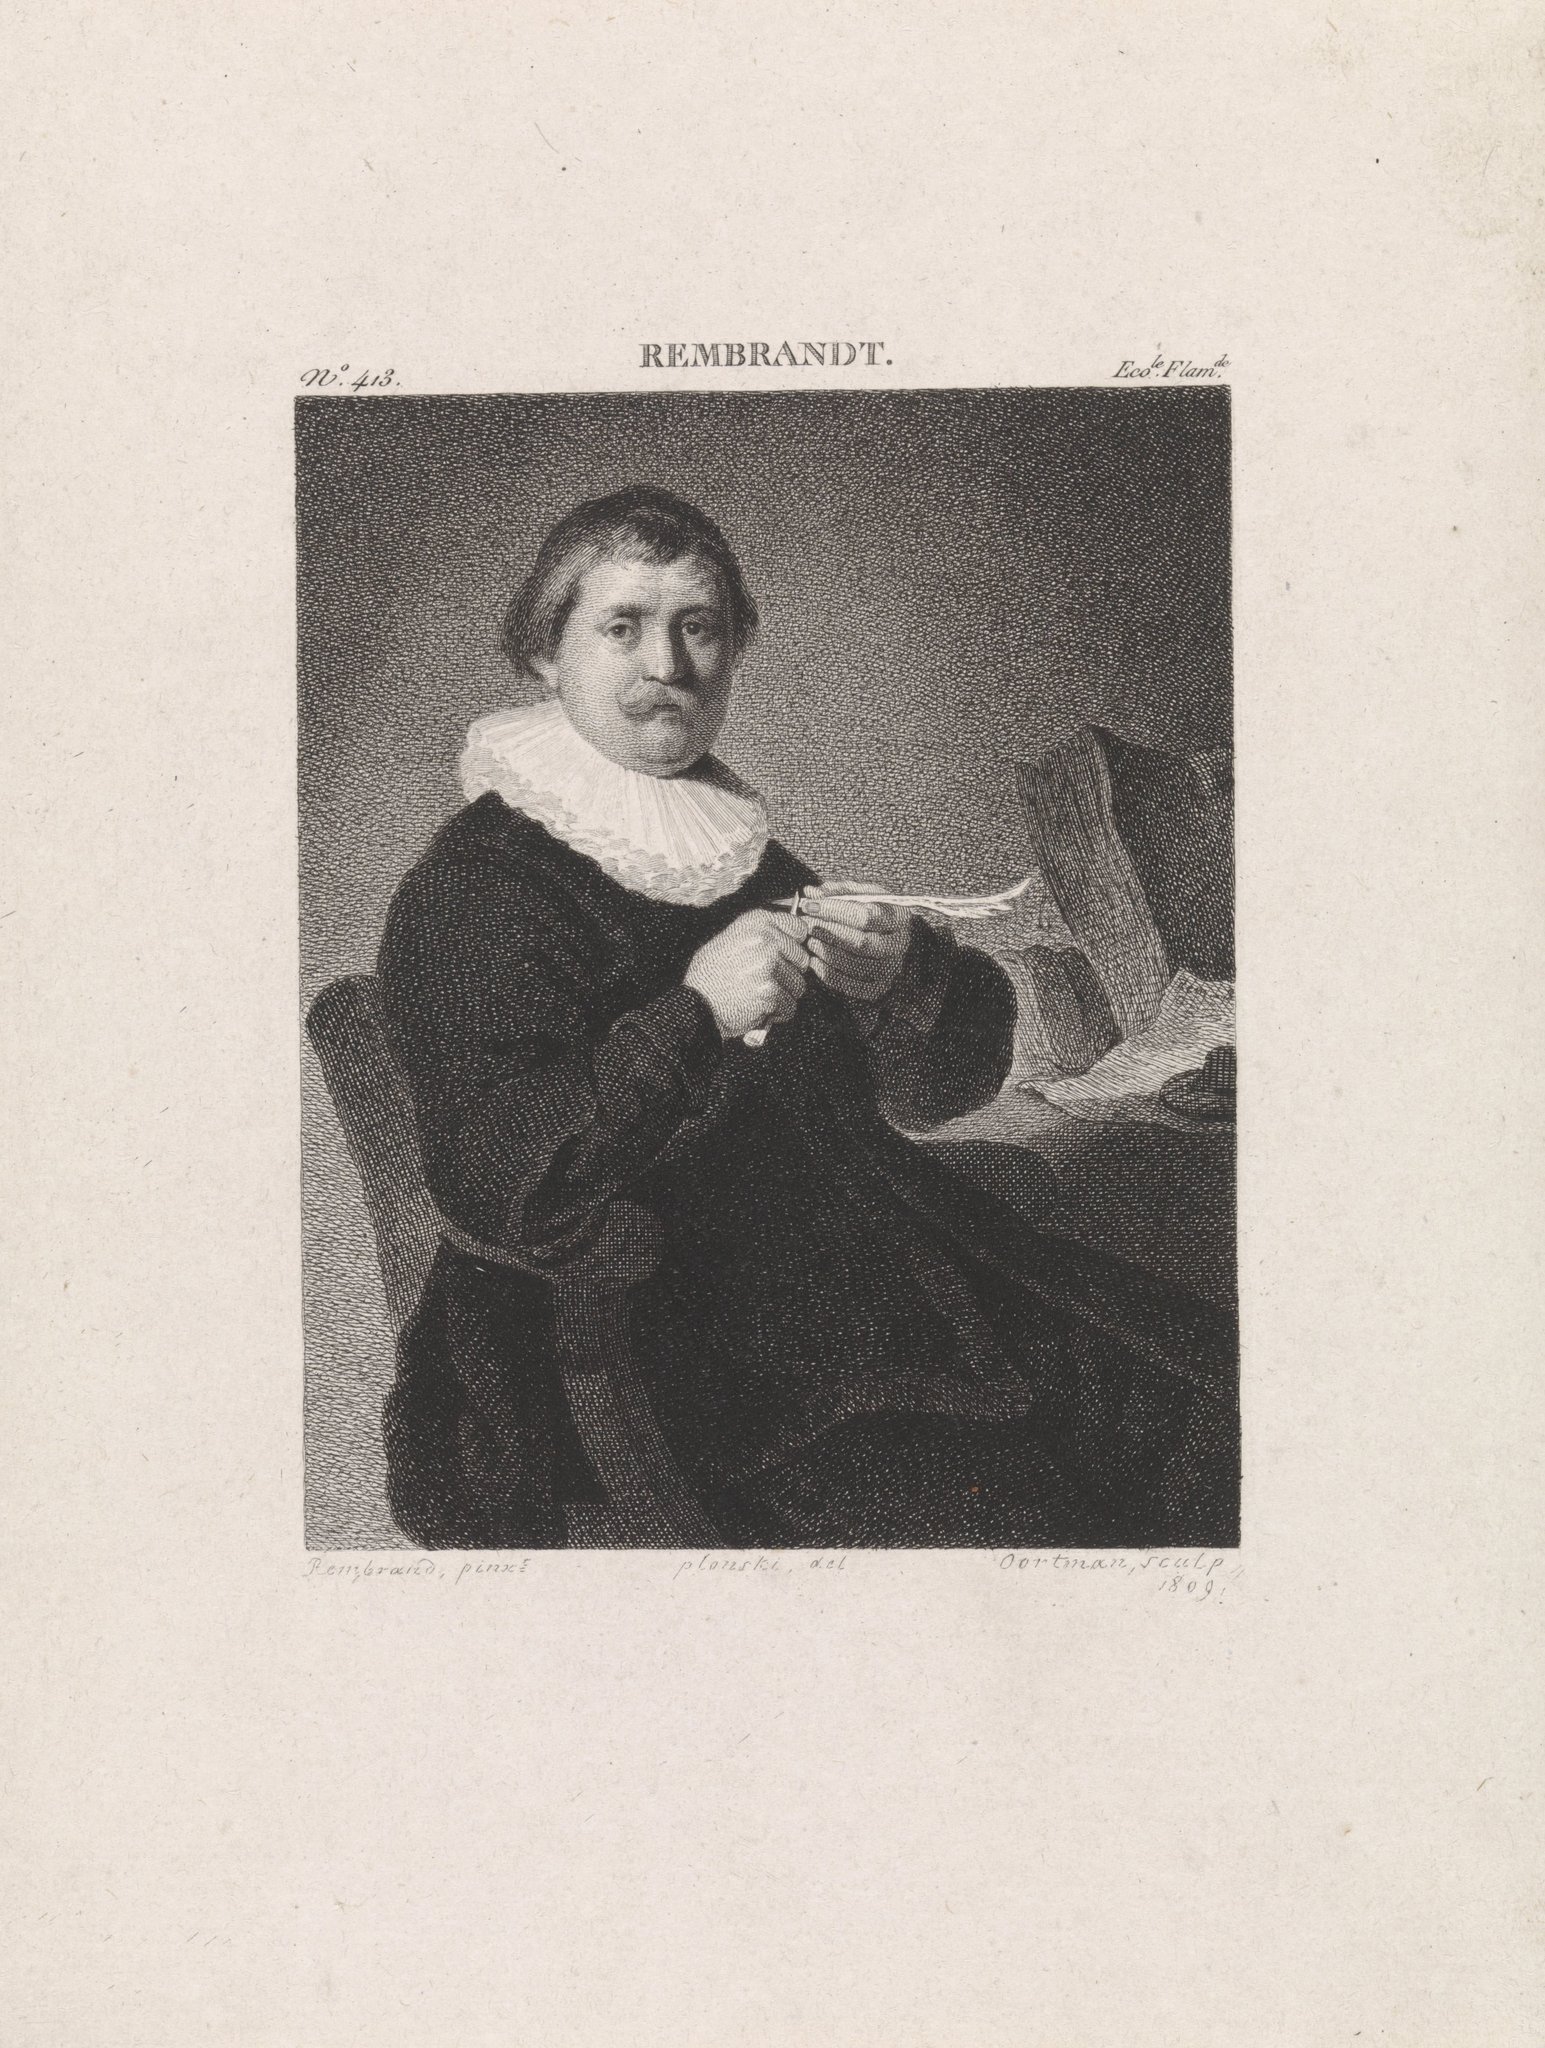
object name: print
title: Portret van schrijfmeester Lieven Willemsz. van Coppenol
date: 1809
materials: paper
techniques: etching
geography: paris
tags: amsterdam, draughtsman, lieven willemsz. coppenol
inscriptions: collector's mark: Lugt 2228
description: Portret van de Amsterdamse schrijfmeester Lieven Willemsz. van Coppenol zittend aan zijn schrijftafel. Coppenol snijdt zijn schrijfveer.